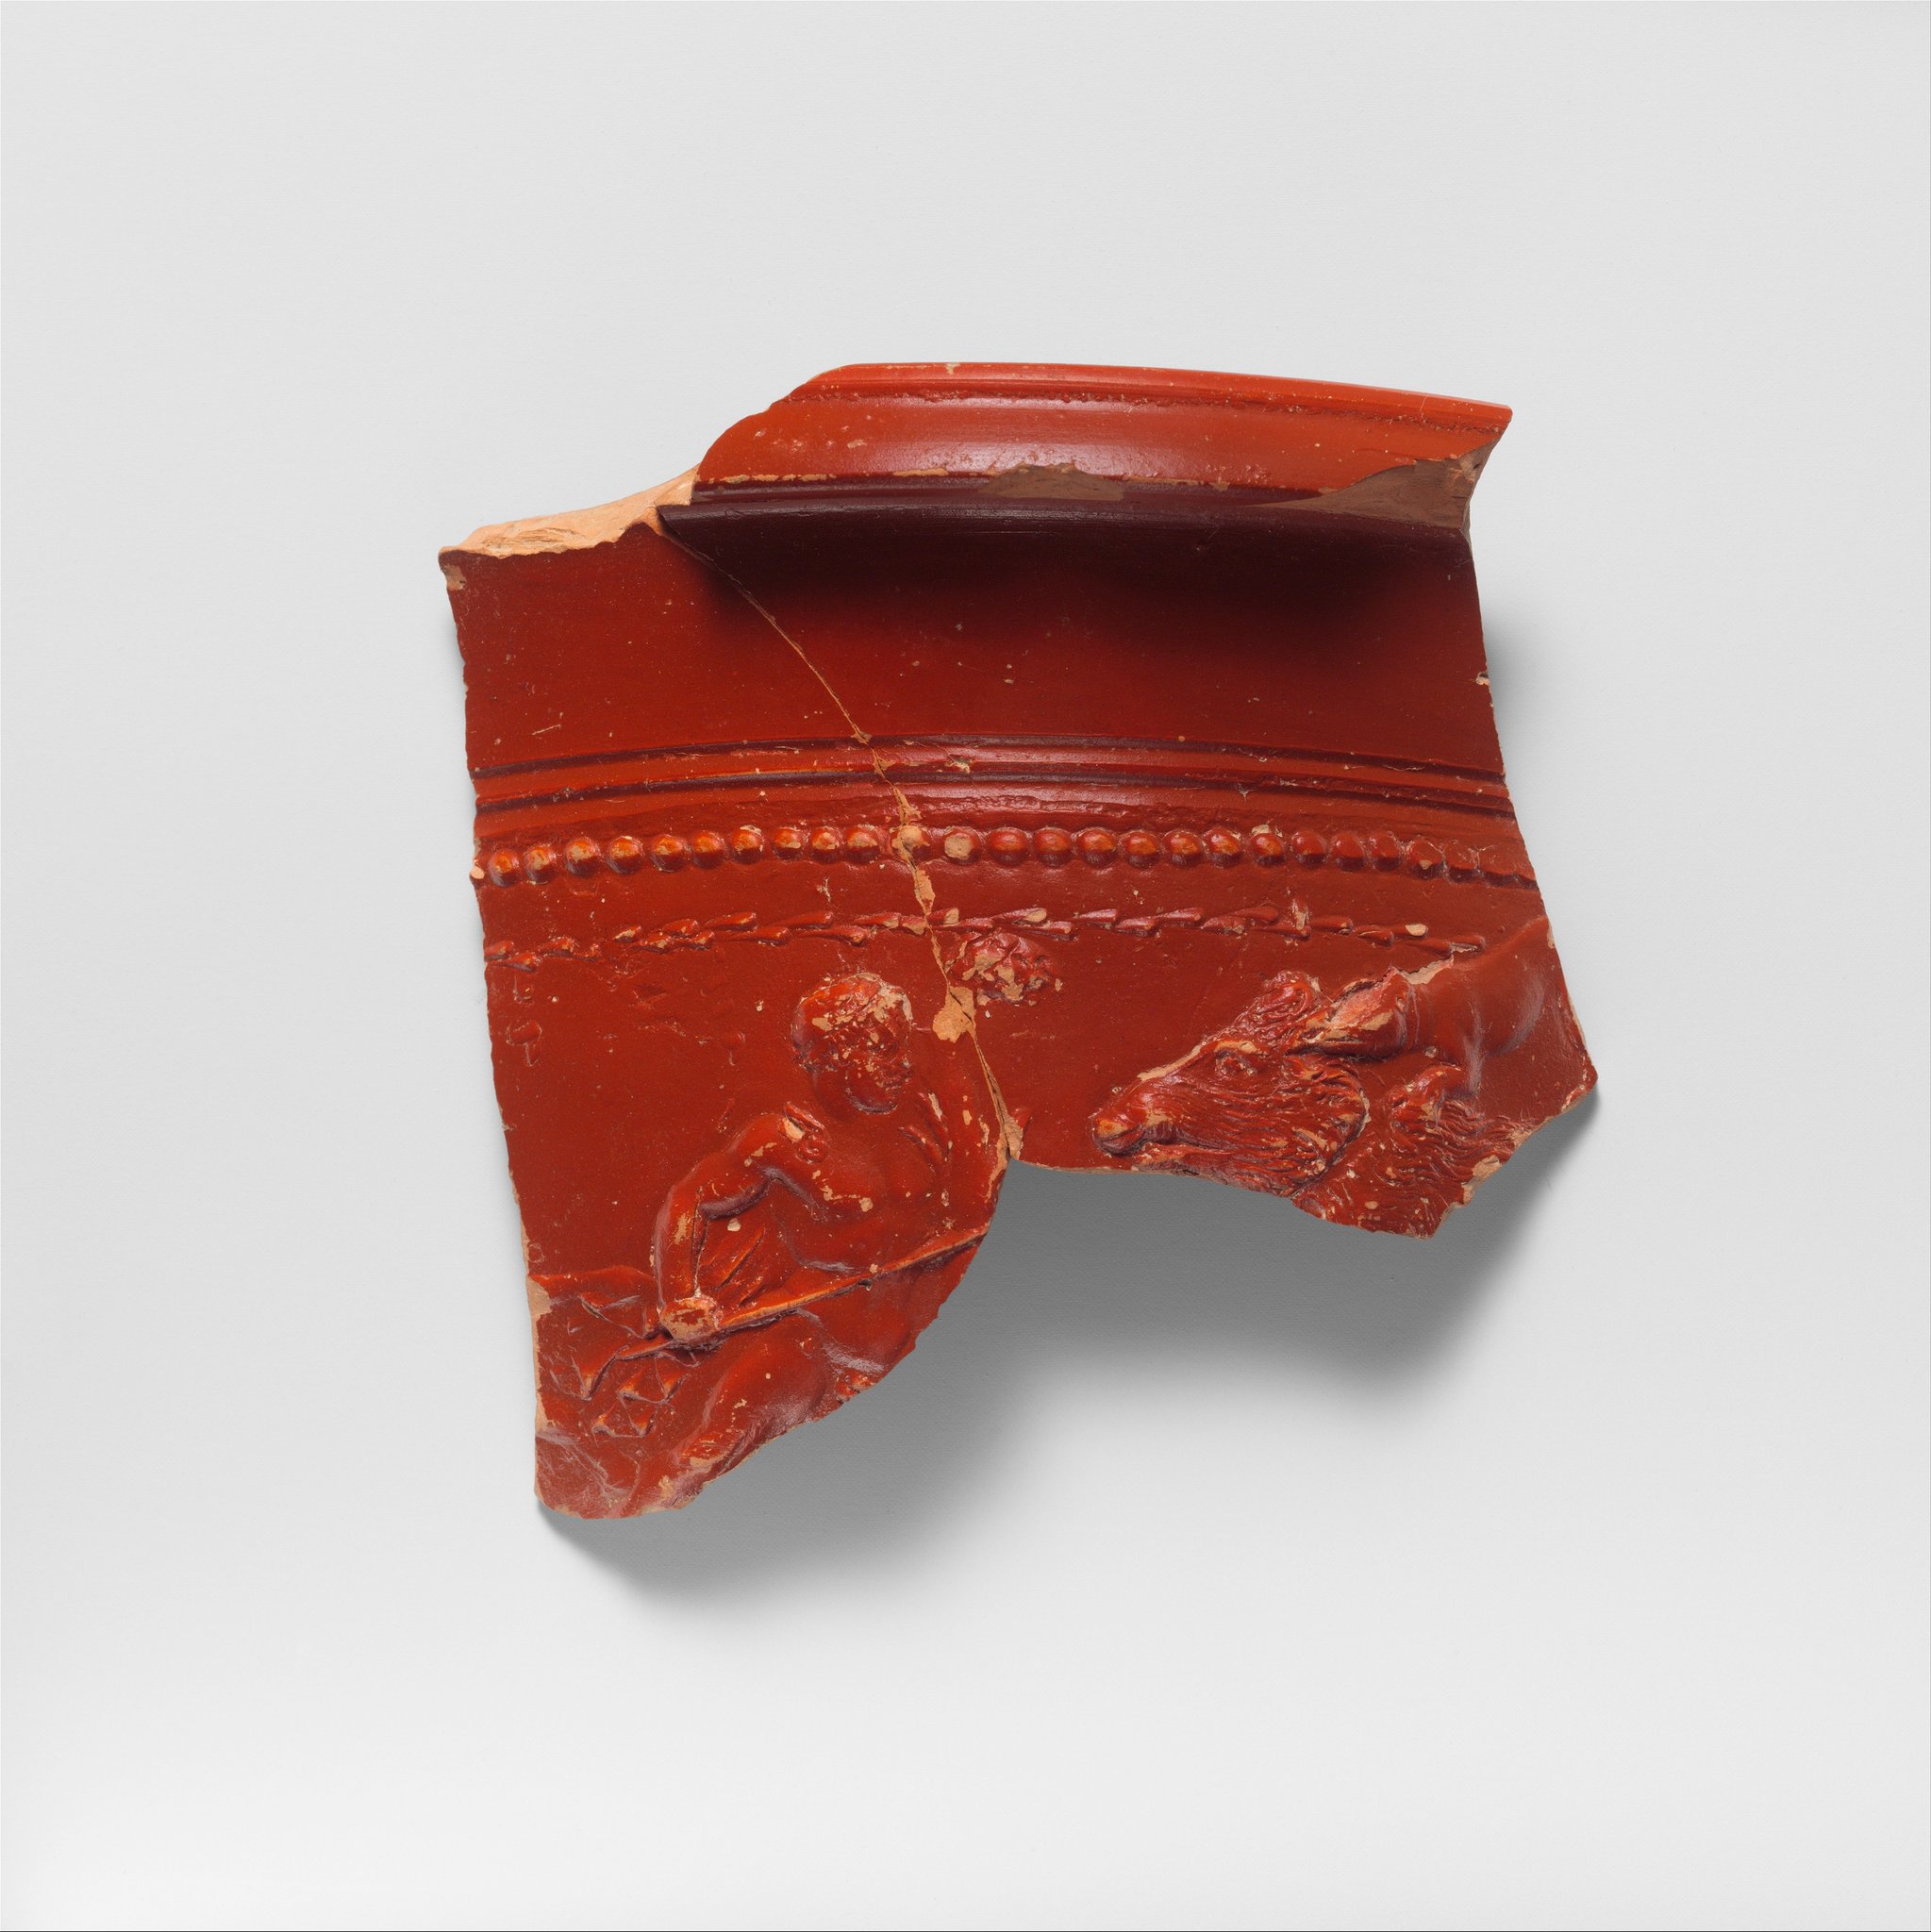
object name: fragment of a bowl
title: Terracotta bowl fragment depicting a boar hunt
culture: roman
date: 1-50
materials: terracotta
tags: men,hunting,boars